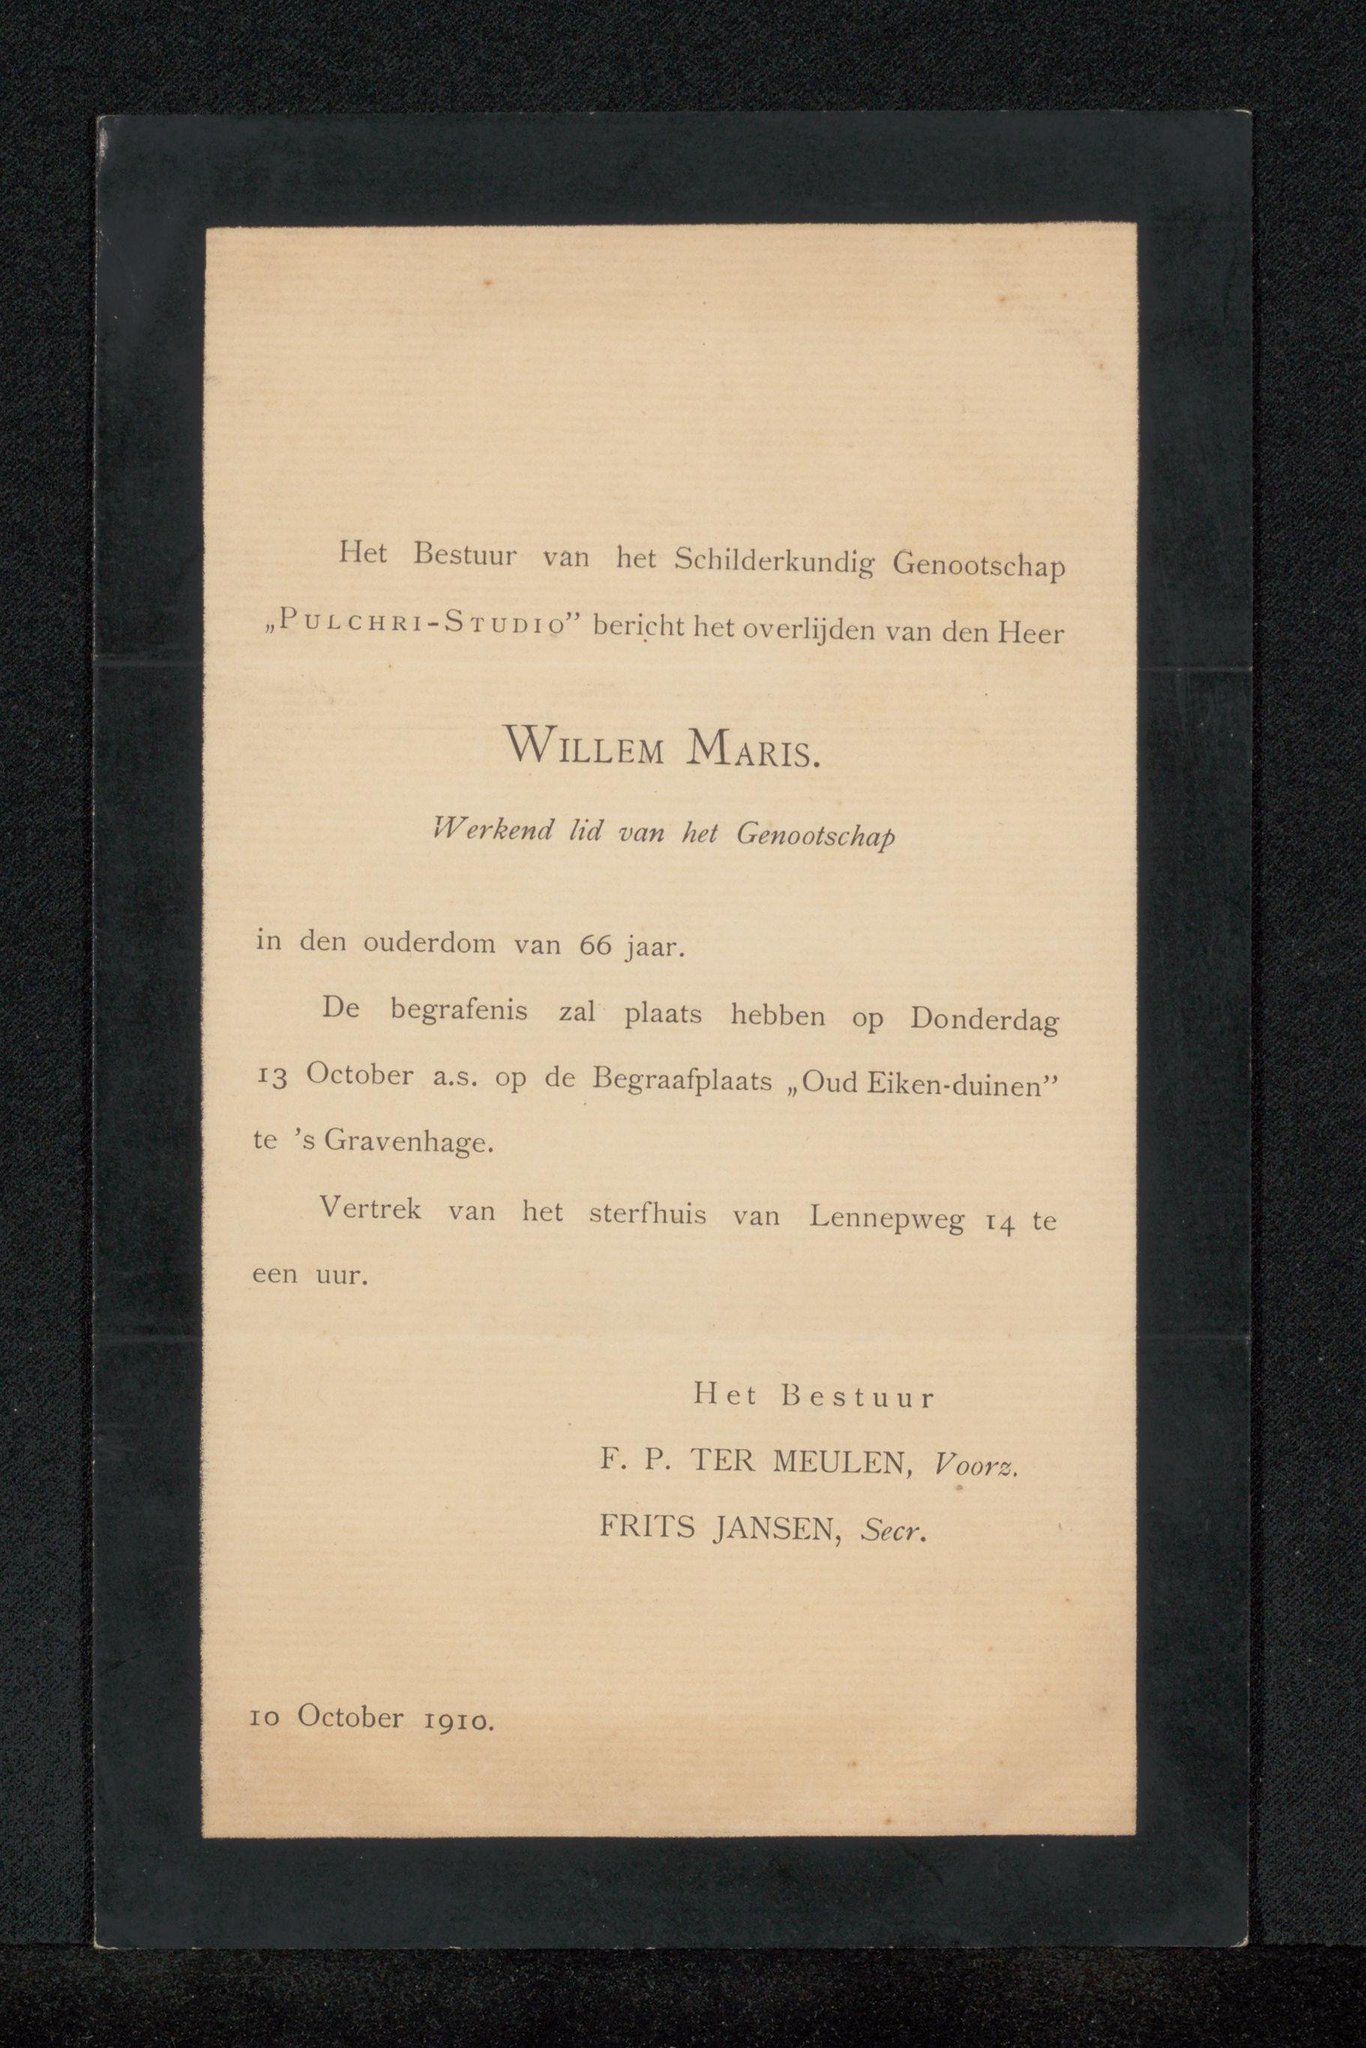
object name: overlijdensbericht, overlijdensadvertentie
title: Overlijdensbericht aan Philip Zilcken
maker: frits jansen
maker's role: painter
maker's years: 1856-1928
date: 1910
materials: paper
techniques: printing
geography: the hague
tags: the hague, painter, draughtsman, willem maris, philip zilcken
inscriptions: collector's mark: ‘RPK’, watermark